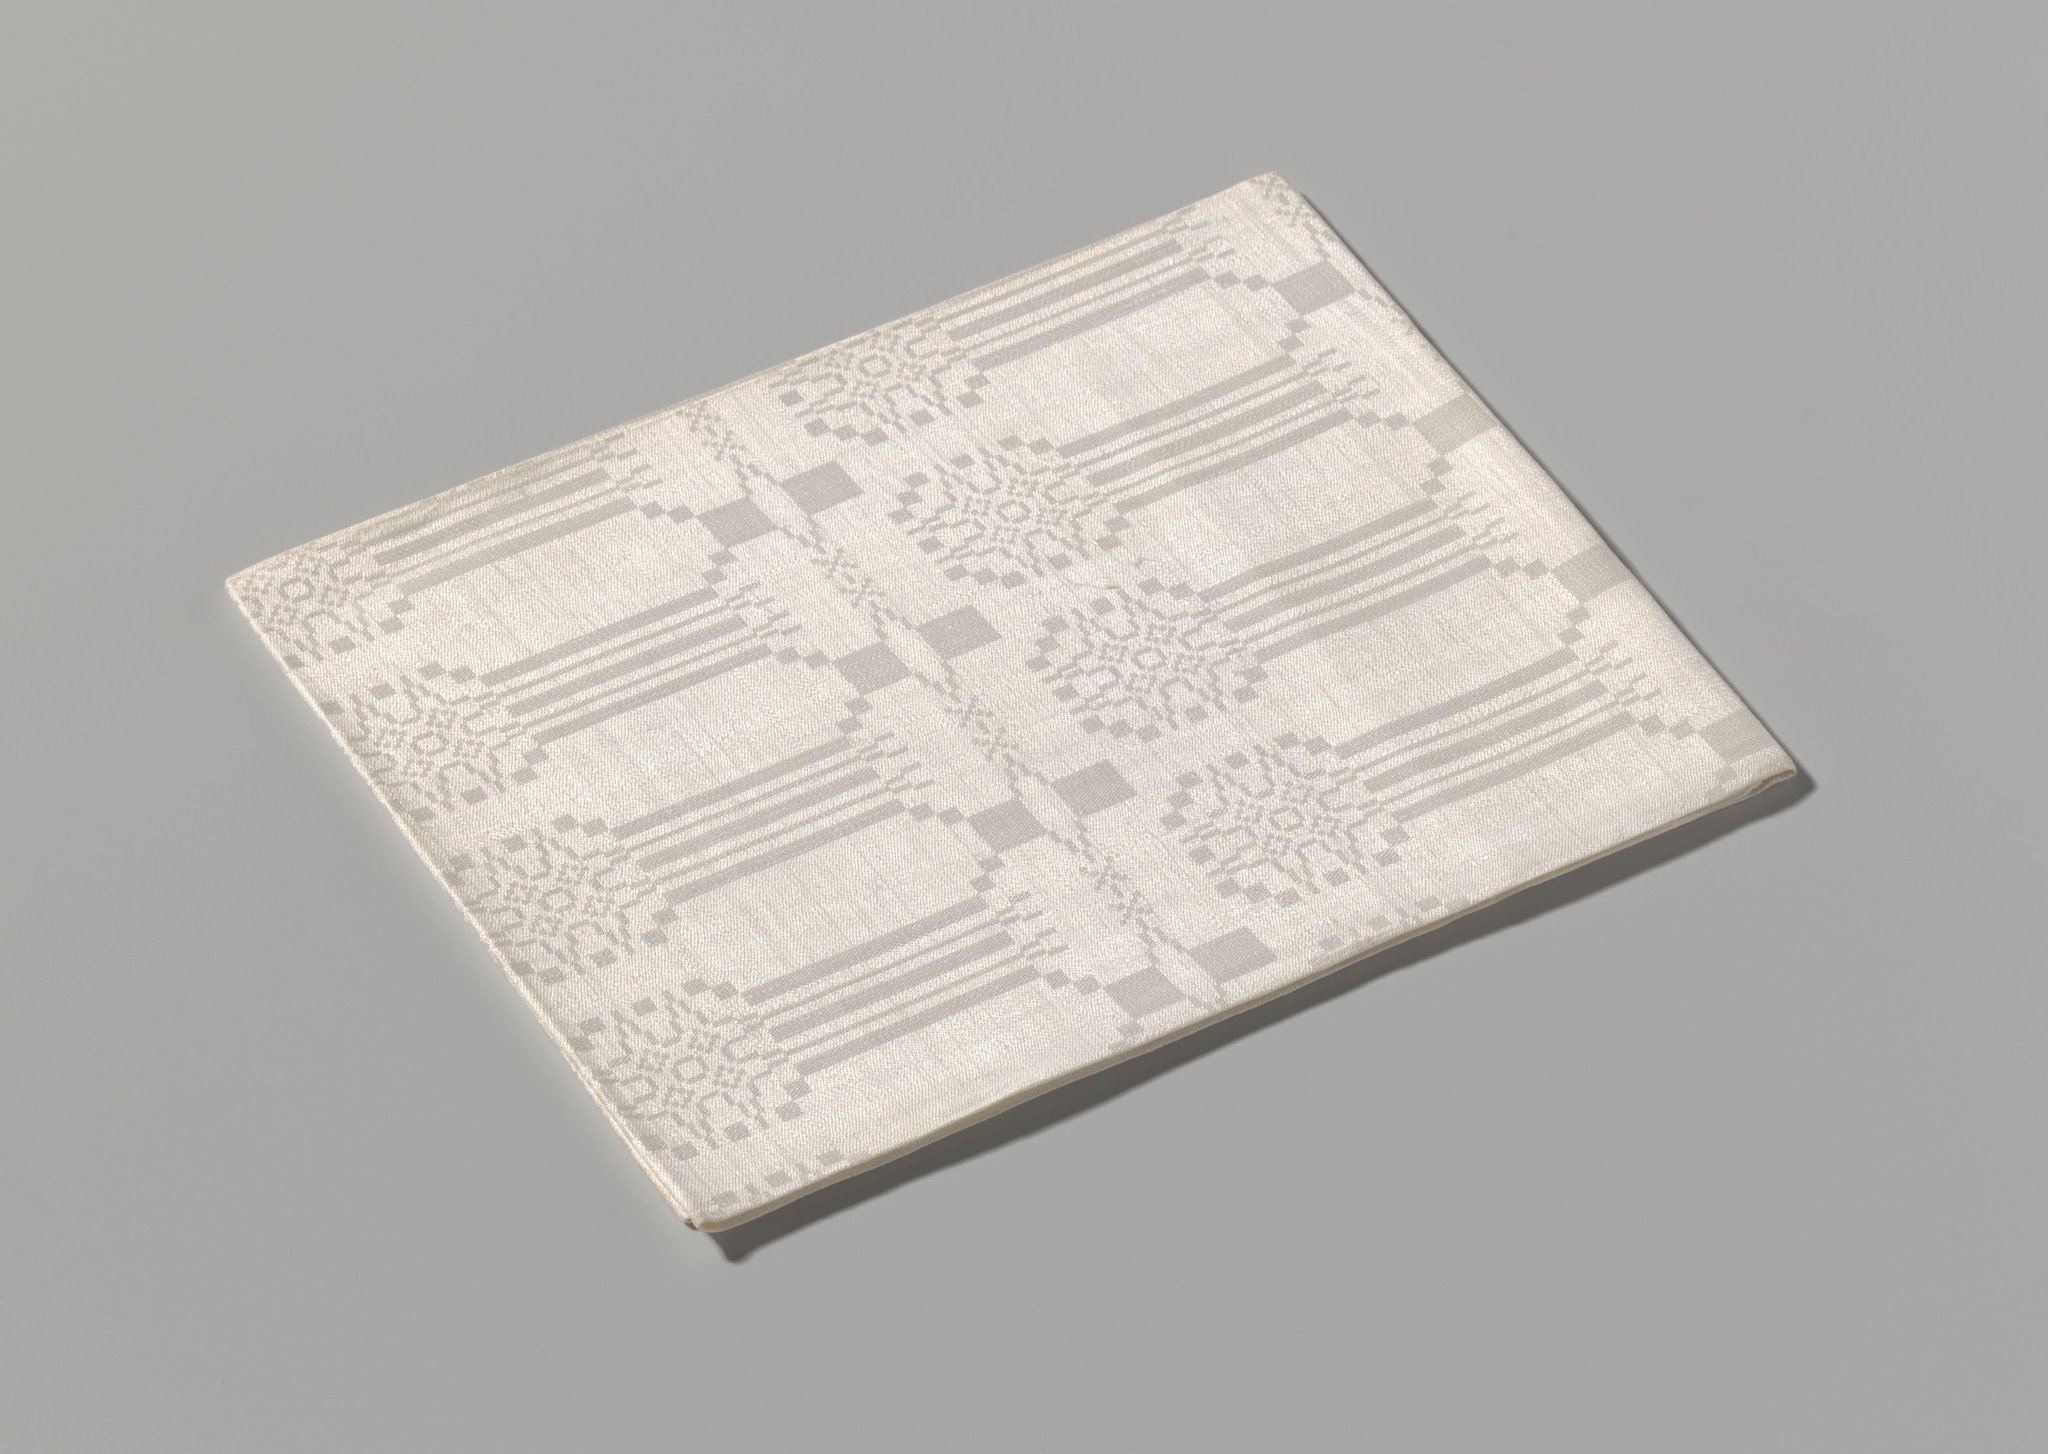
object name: napkin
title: Servet van linnen met pellenpatroon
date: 1723-1769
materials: linen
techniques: peeled fabric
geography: northern netherlands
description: wit linnen servet met pellen patroon, z.g.Oranjeboom, merk kroon WG 49